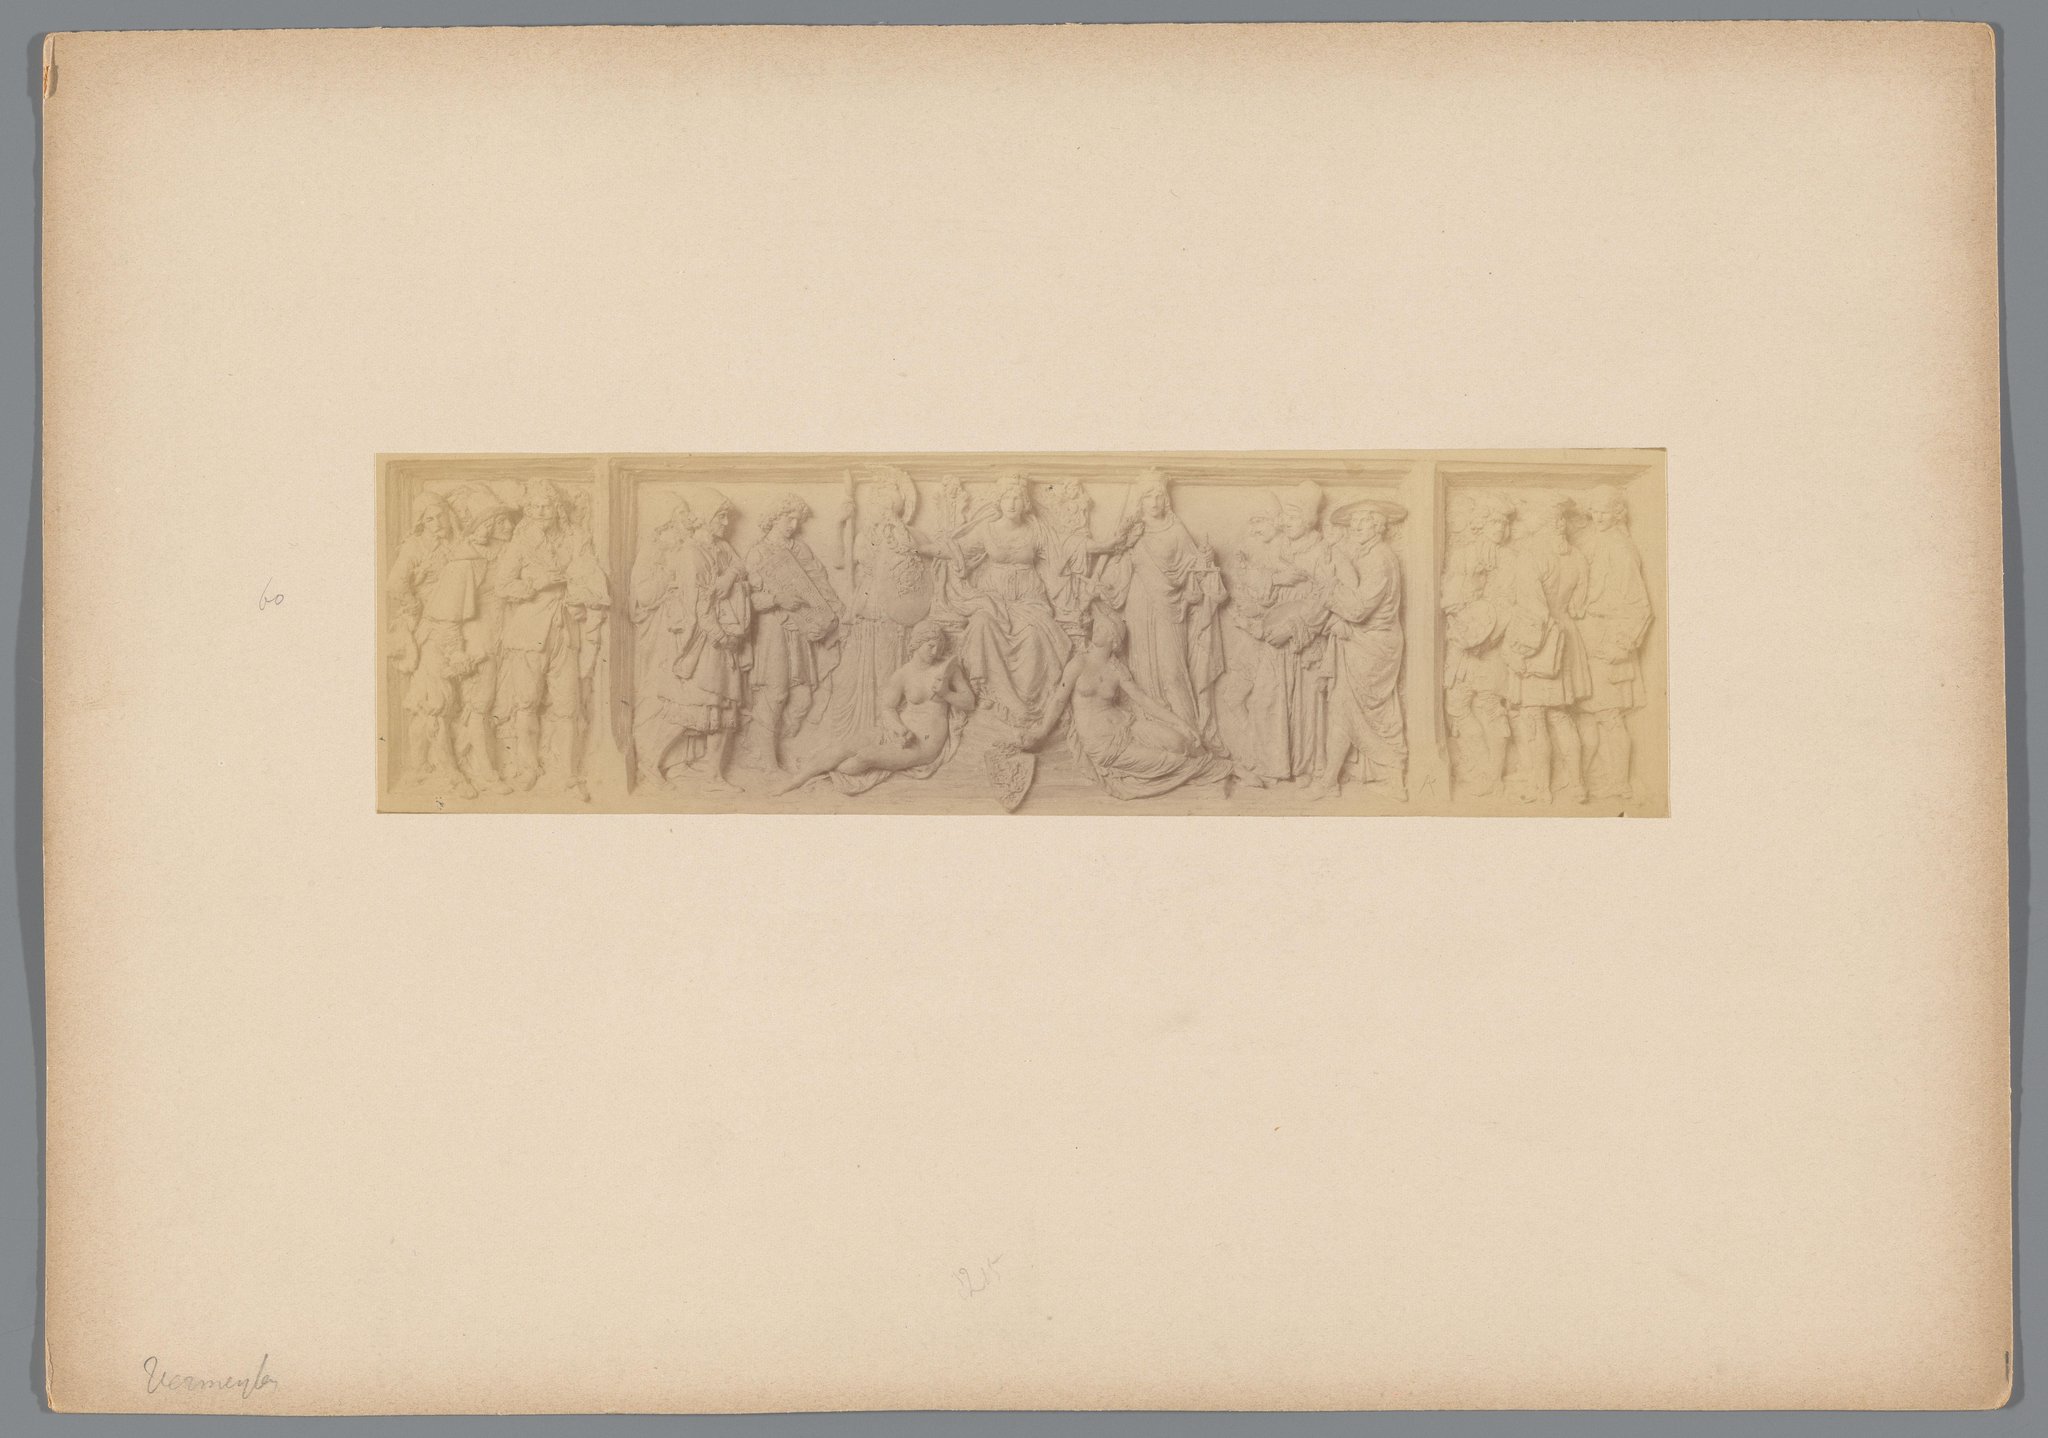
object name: reproduction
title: Modellen van beeldhouwwerken voor een prijsvraag uitgeschreven door het Rijksmuseum Amsterdam, 1880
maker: Anonymous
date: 1880-1887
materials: cardboard, paper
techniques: albumen print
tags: piece of sculpture, reproduction of a piece of sculpture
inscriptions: collector's mark: Lugt 2228, inscription: ‘215/ 60’, inscription: ‘Vermeylen’